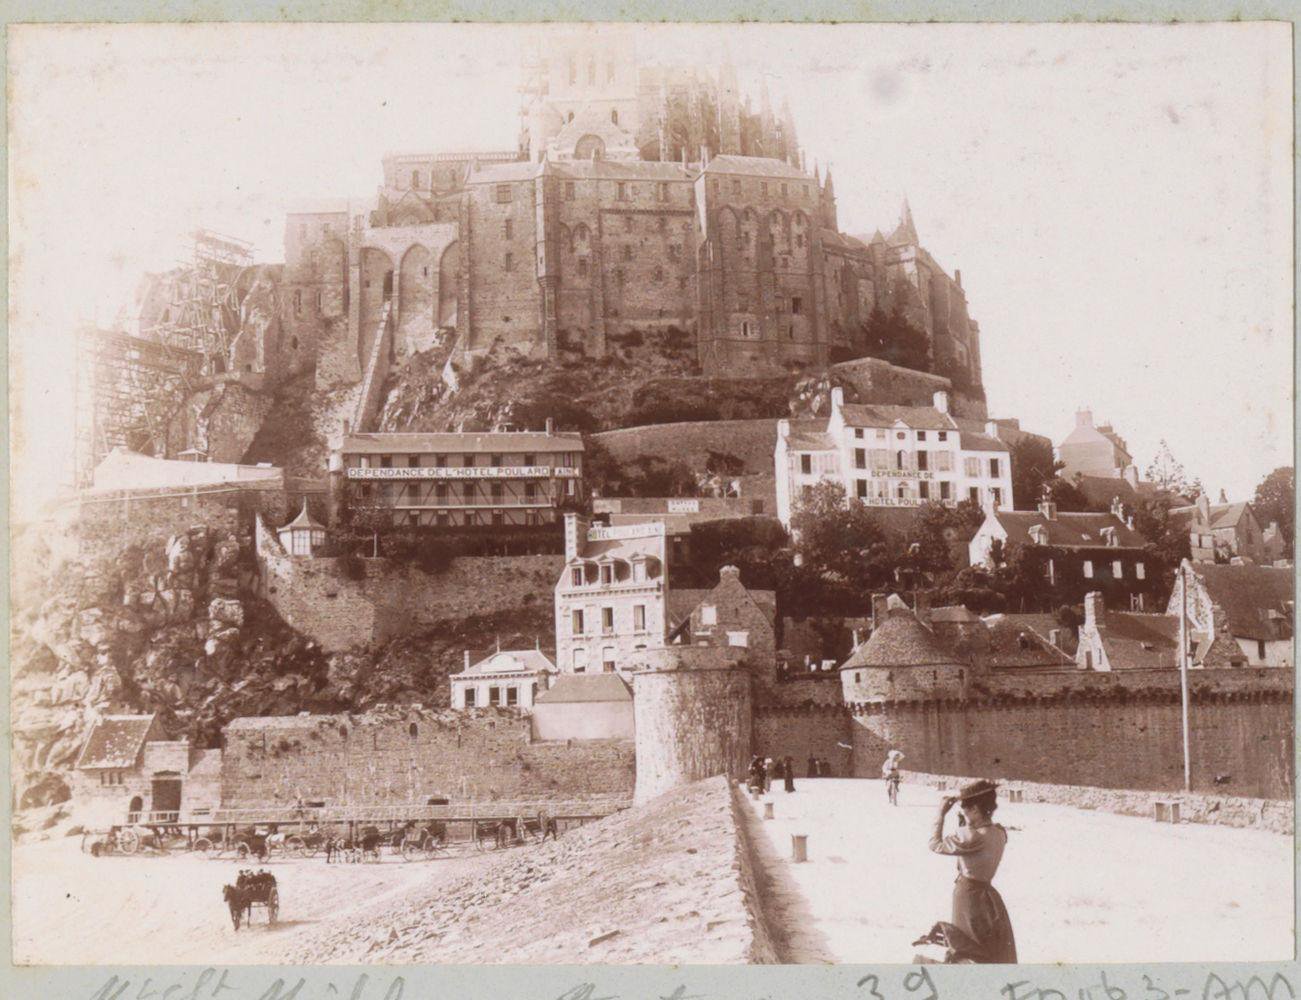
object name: photograph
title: Gezicht op Mont-Saint-Michel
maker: delizy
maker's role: manufacturer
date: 1808-1896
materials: paper, photographic support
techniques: gelatin silver print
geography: mont-saint-michel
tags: prospect of city, town panorama, silhouette of city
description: Onderdeel van Fotoalbum van een Franse amateurfotograaf met opnames van uitstapjes in Frankrijk, Spanje, België, Luxemburg en Nederland, de eerste automobielen en autoraces.